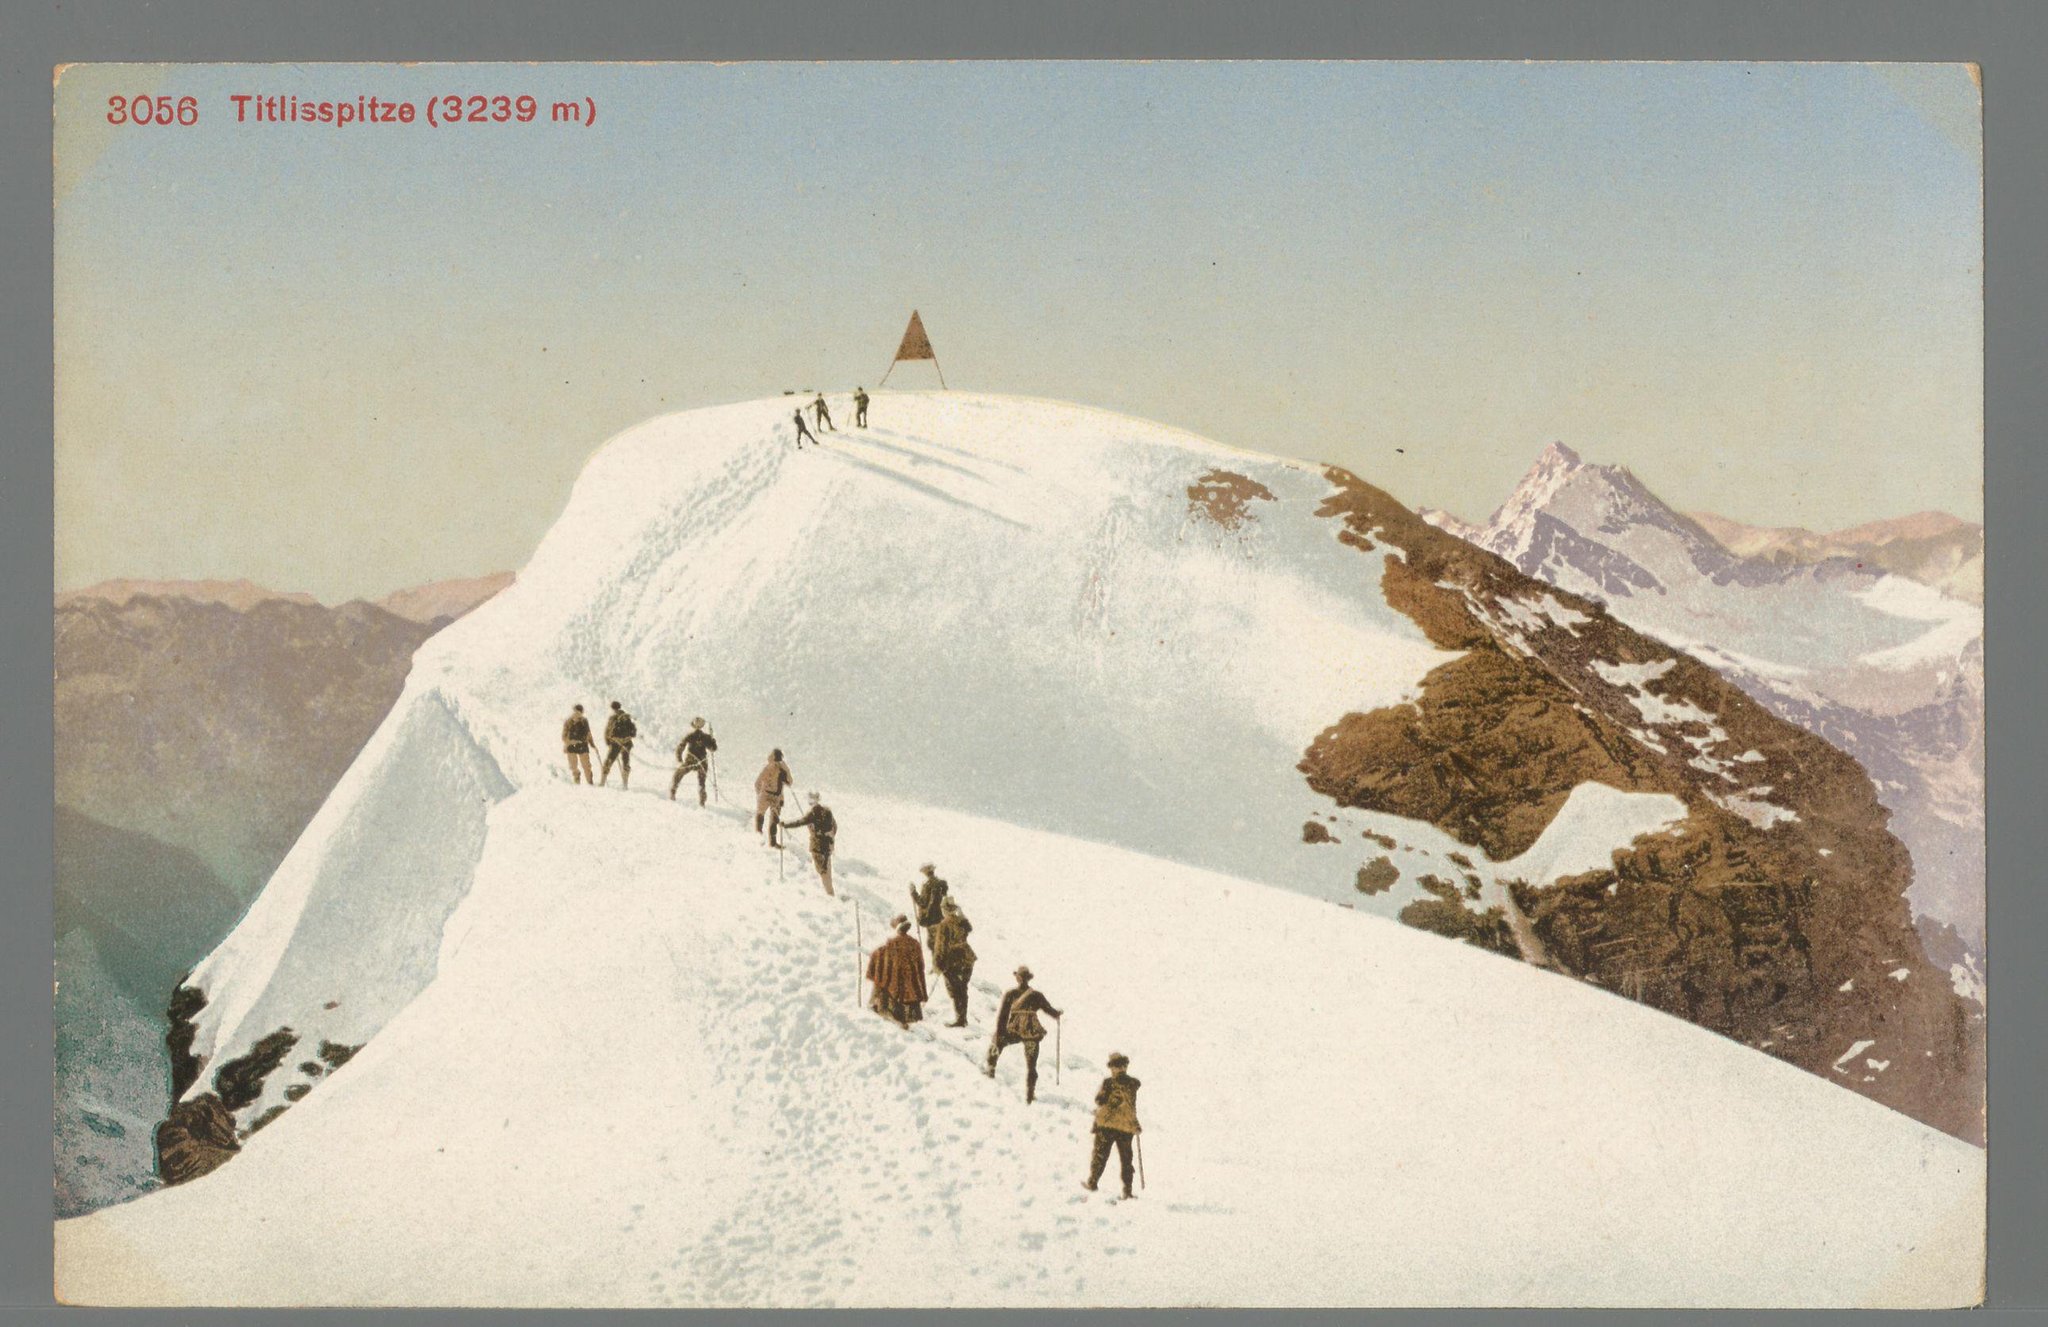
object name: ansichtkaart, prentbriefkaart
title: Titlisspitze (3239 m)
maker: Anonymous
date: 1905-1920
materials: cardboard, photographic process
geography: titlis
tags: mountain-range, snow peaks (+ landscape with figures, staffage)